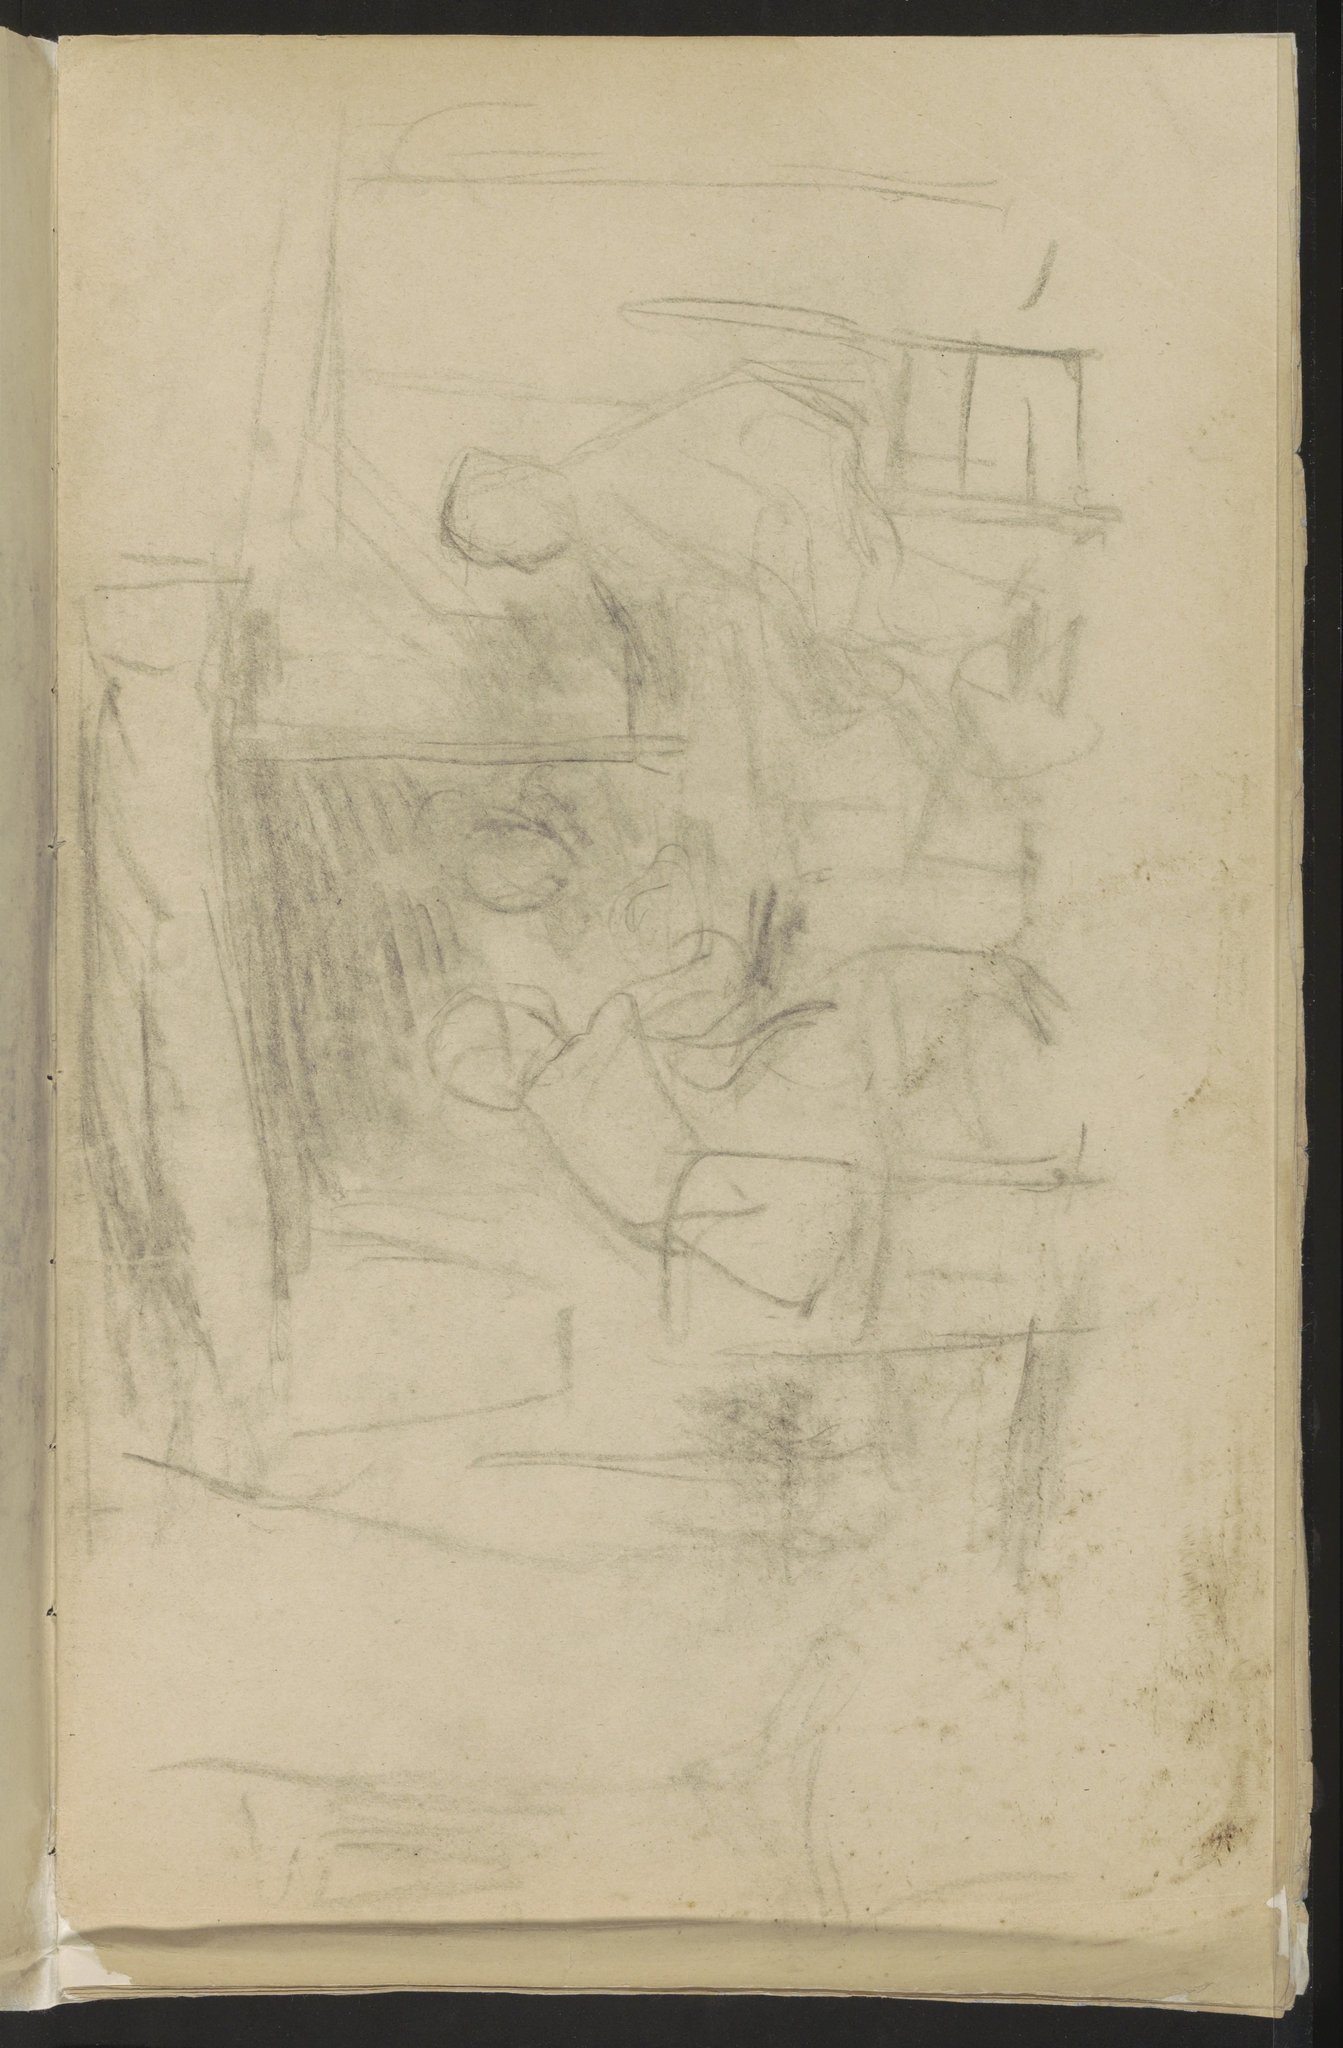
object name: sketchbook leaf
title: Interieur met drie figuren rondom een tafel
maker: albert neuhuys (1844-1914)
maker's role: draughtsman, painter, print maker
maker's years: 1844-1914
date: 1854-1914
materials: charcoal, paper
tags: sitting figure, table, interior of the house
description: Recto-zijde van een ongenummerde pagina tussen bladzijde 1 en 2 uit een schetsboek met 53 bladen.